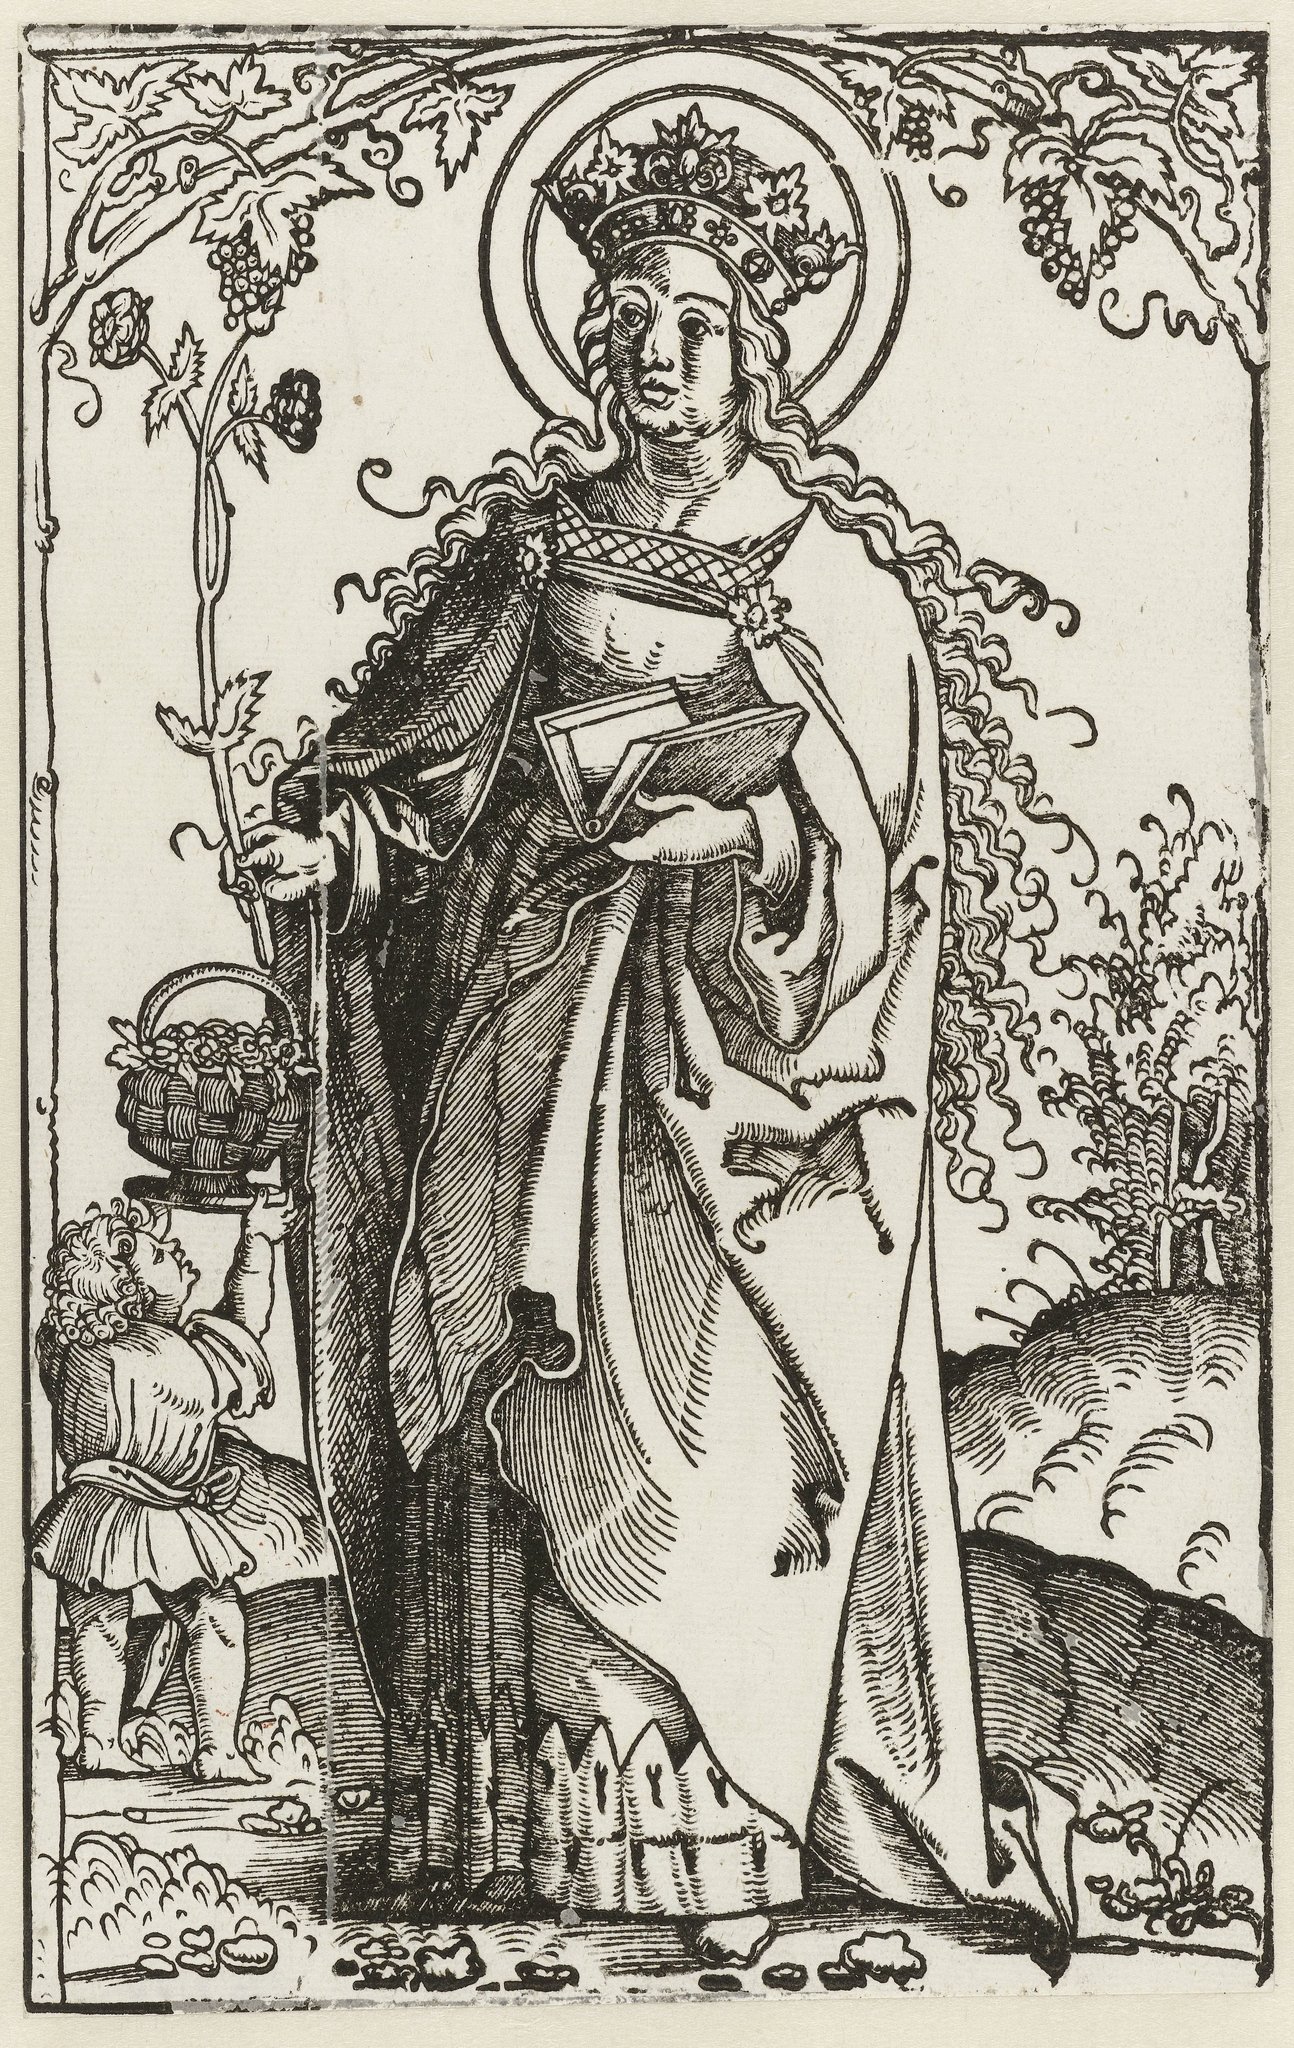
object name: print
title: Heilige Dorothea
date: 1519-1520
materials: paper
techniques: woodcut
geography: nuremberg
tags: the virgin martyr dorothea of caesarea; possible attributes: basket of roses and apples, child with basket of roses, garland of roses, roses in hand or lap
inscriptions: collector's mark: Lugt 2228, collector's mark: Lugt 240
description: Op een eerdere staat van deze prent is niet de heilige Dorothea, maar de heilige Ursula voorgesteld: een dame met pijlen bij zich, in plaats van een rozentak en een kind. Klinkert, C.